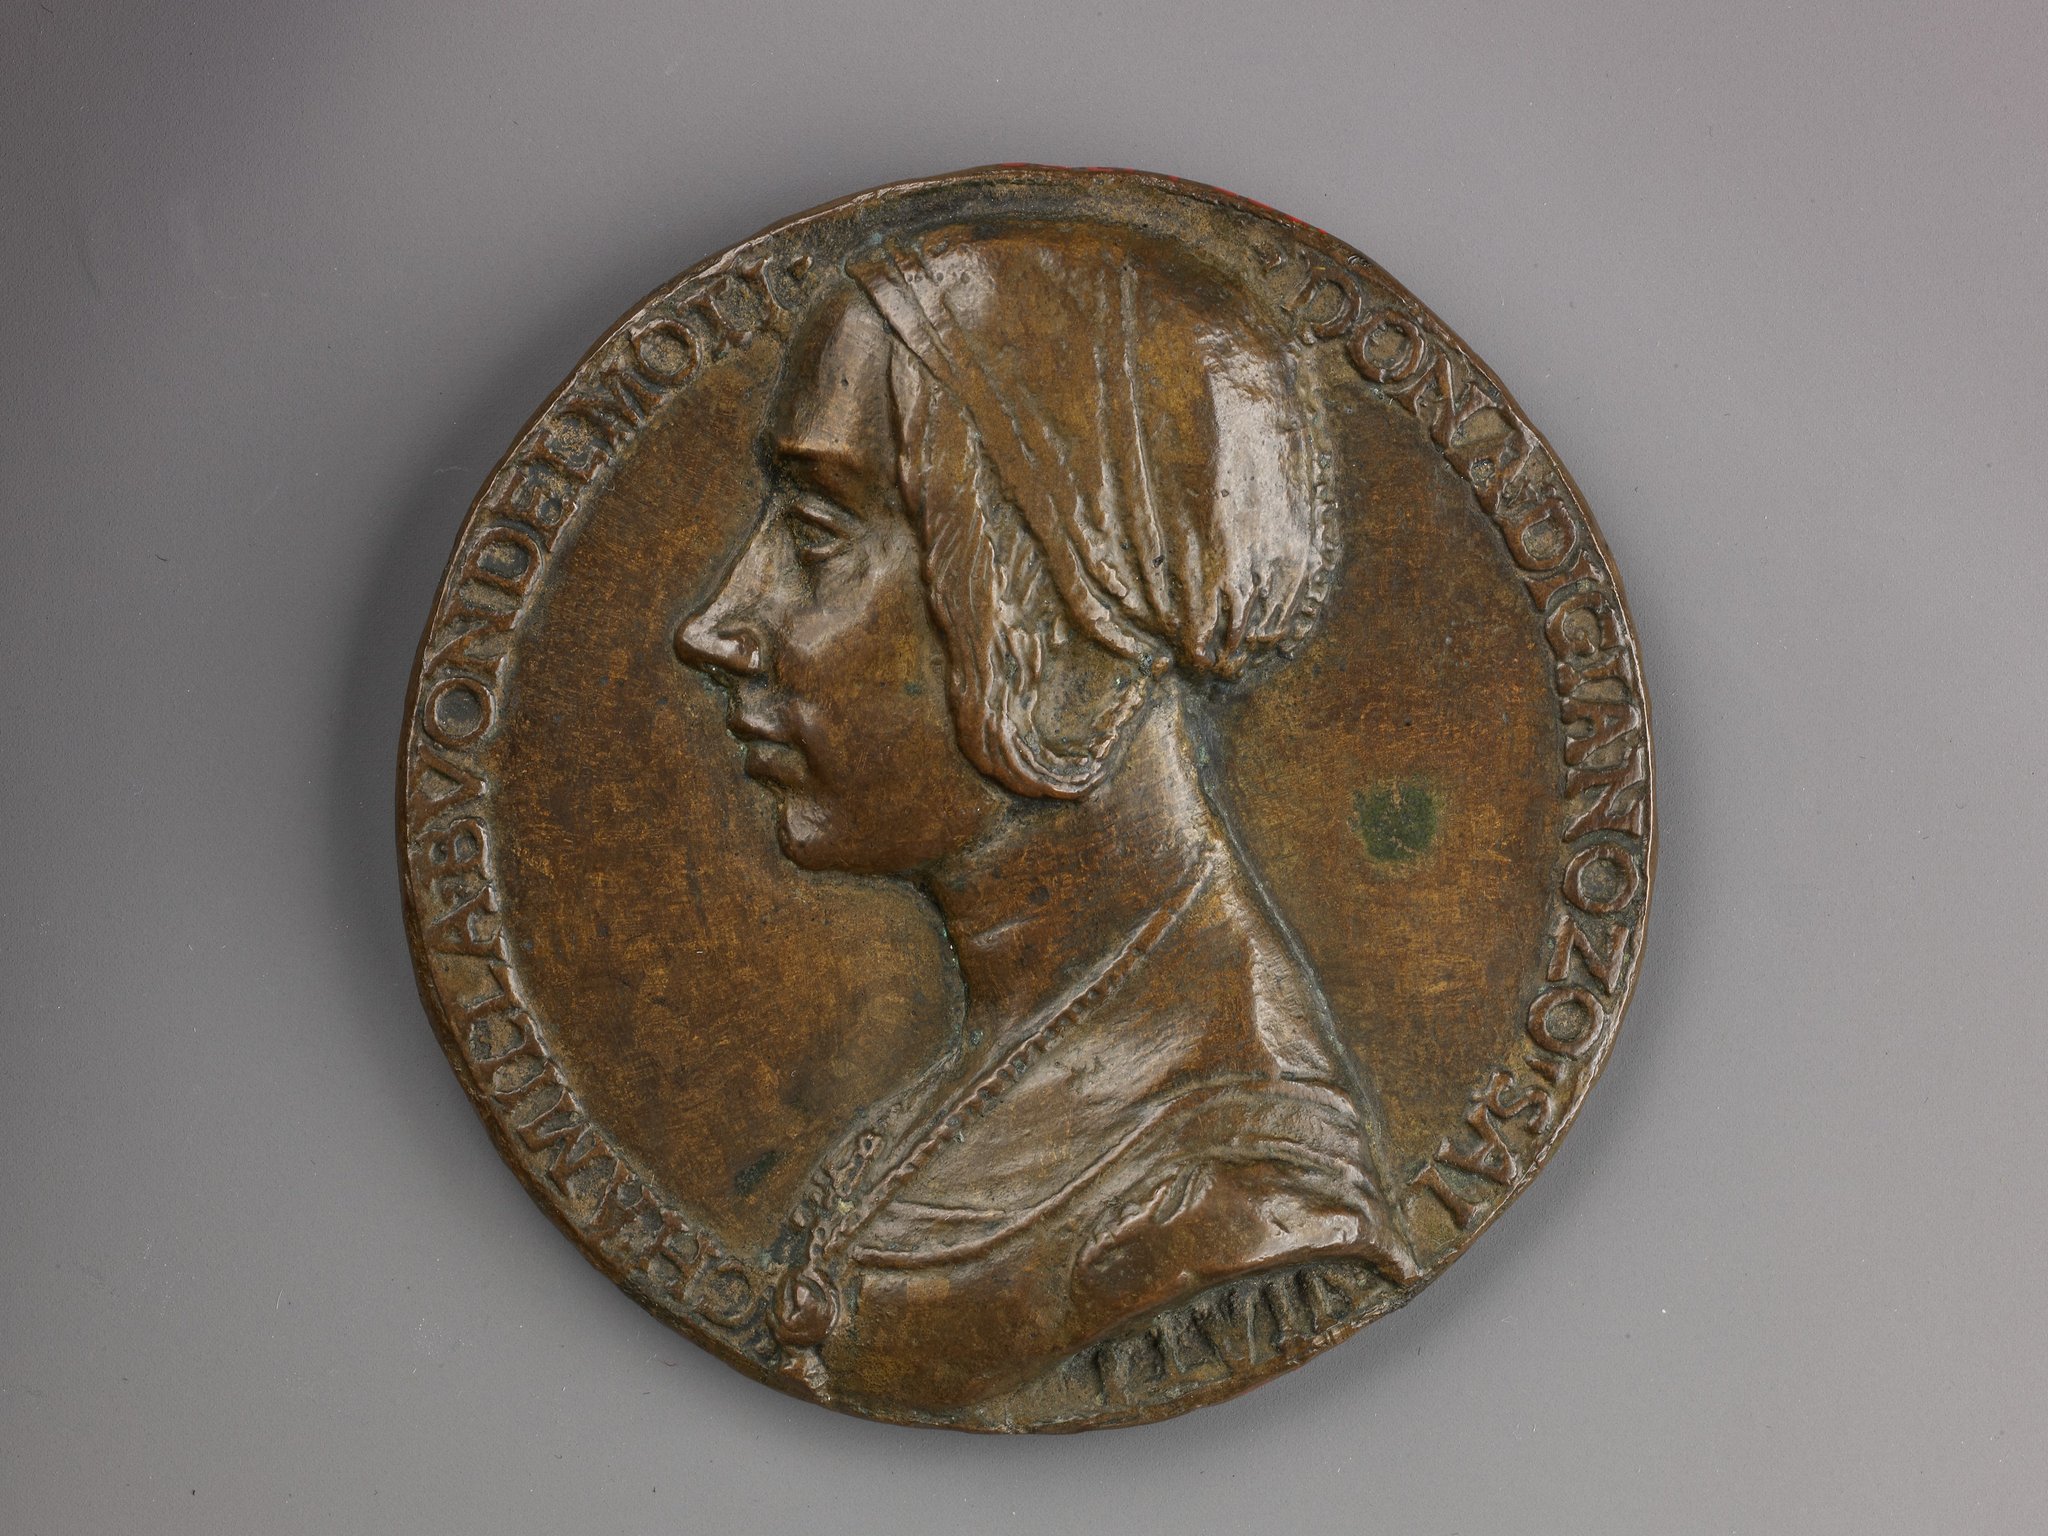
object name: medal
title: Portrait medal of Camilla Buondelmonti Salviati (obverse); Personification of Hope (reverse)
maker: niccolò fiorentino (niccolò di forzore spinelli)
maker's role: artist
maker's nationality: italian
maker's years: 1430-1514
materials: bronze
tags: women